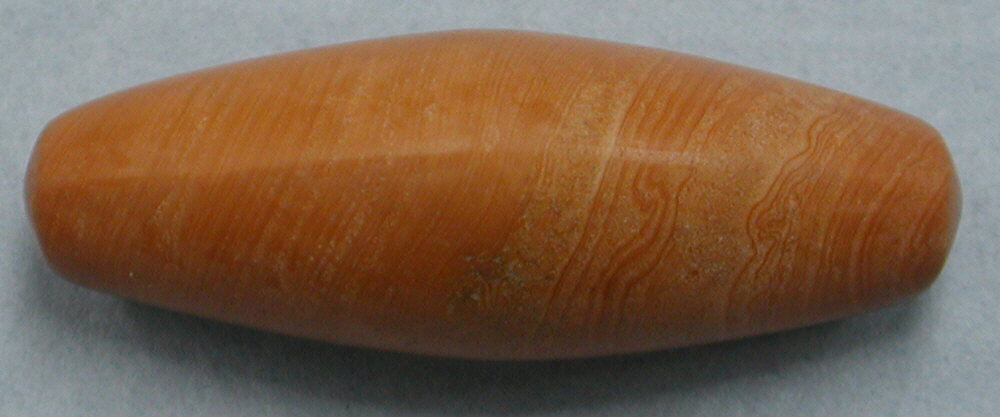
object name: ritual stone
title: Polishing Stone (pulidor)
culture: mexican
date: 1501-1600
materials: stone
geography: mexico